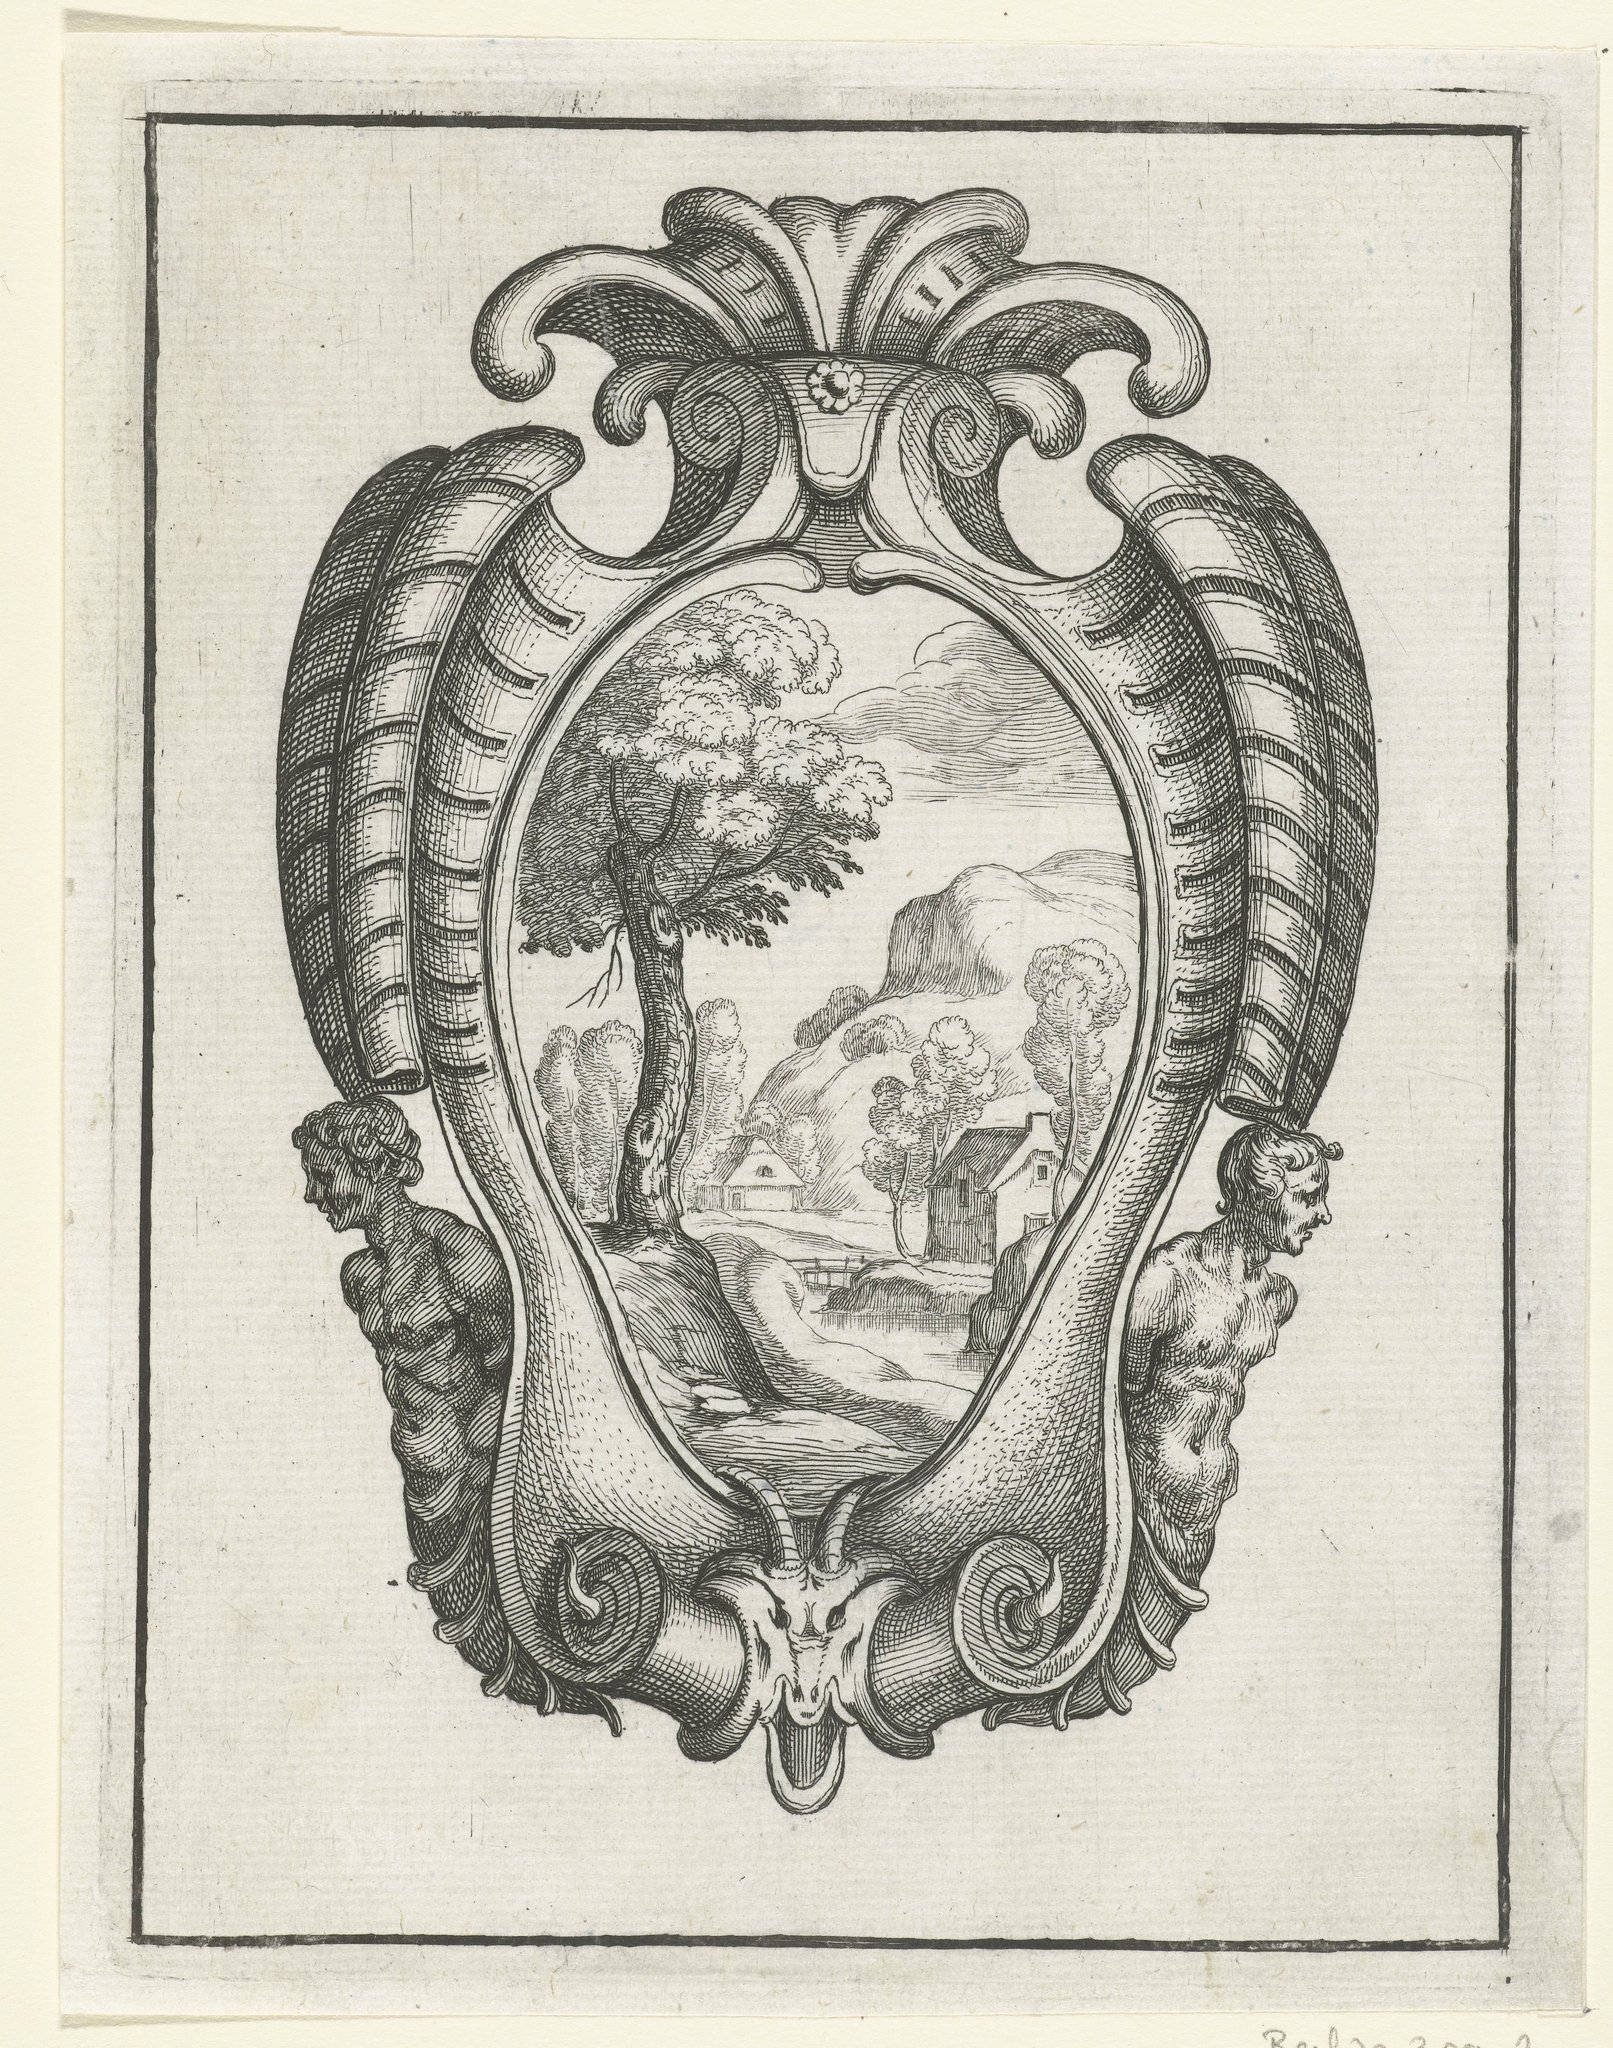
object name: ornament print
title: Cartouche met twee mannelijke torso's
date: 1632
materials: paper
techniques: engraving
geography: france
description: In de cartouche staat een berglandschap afgebeeld. Blad 10 uit serie van 13 bladen met cartouches in Franse kwabstijl.